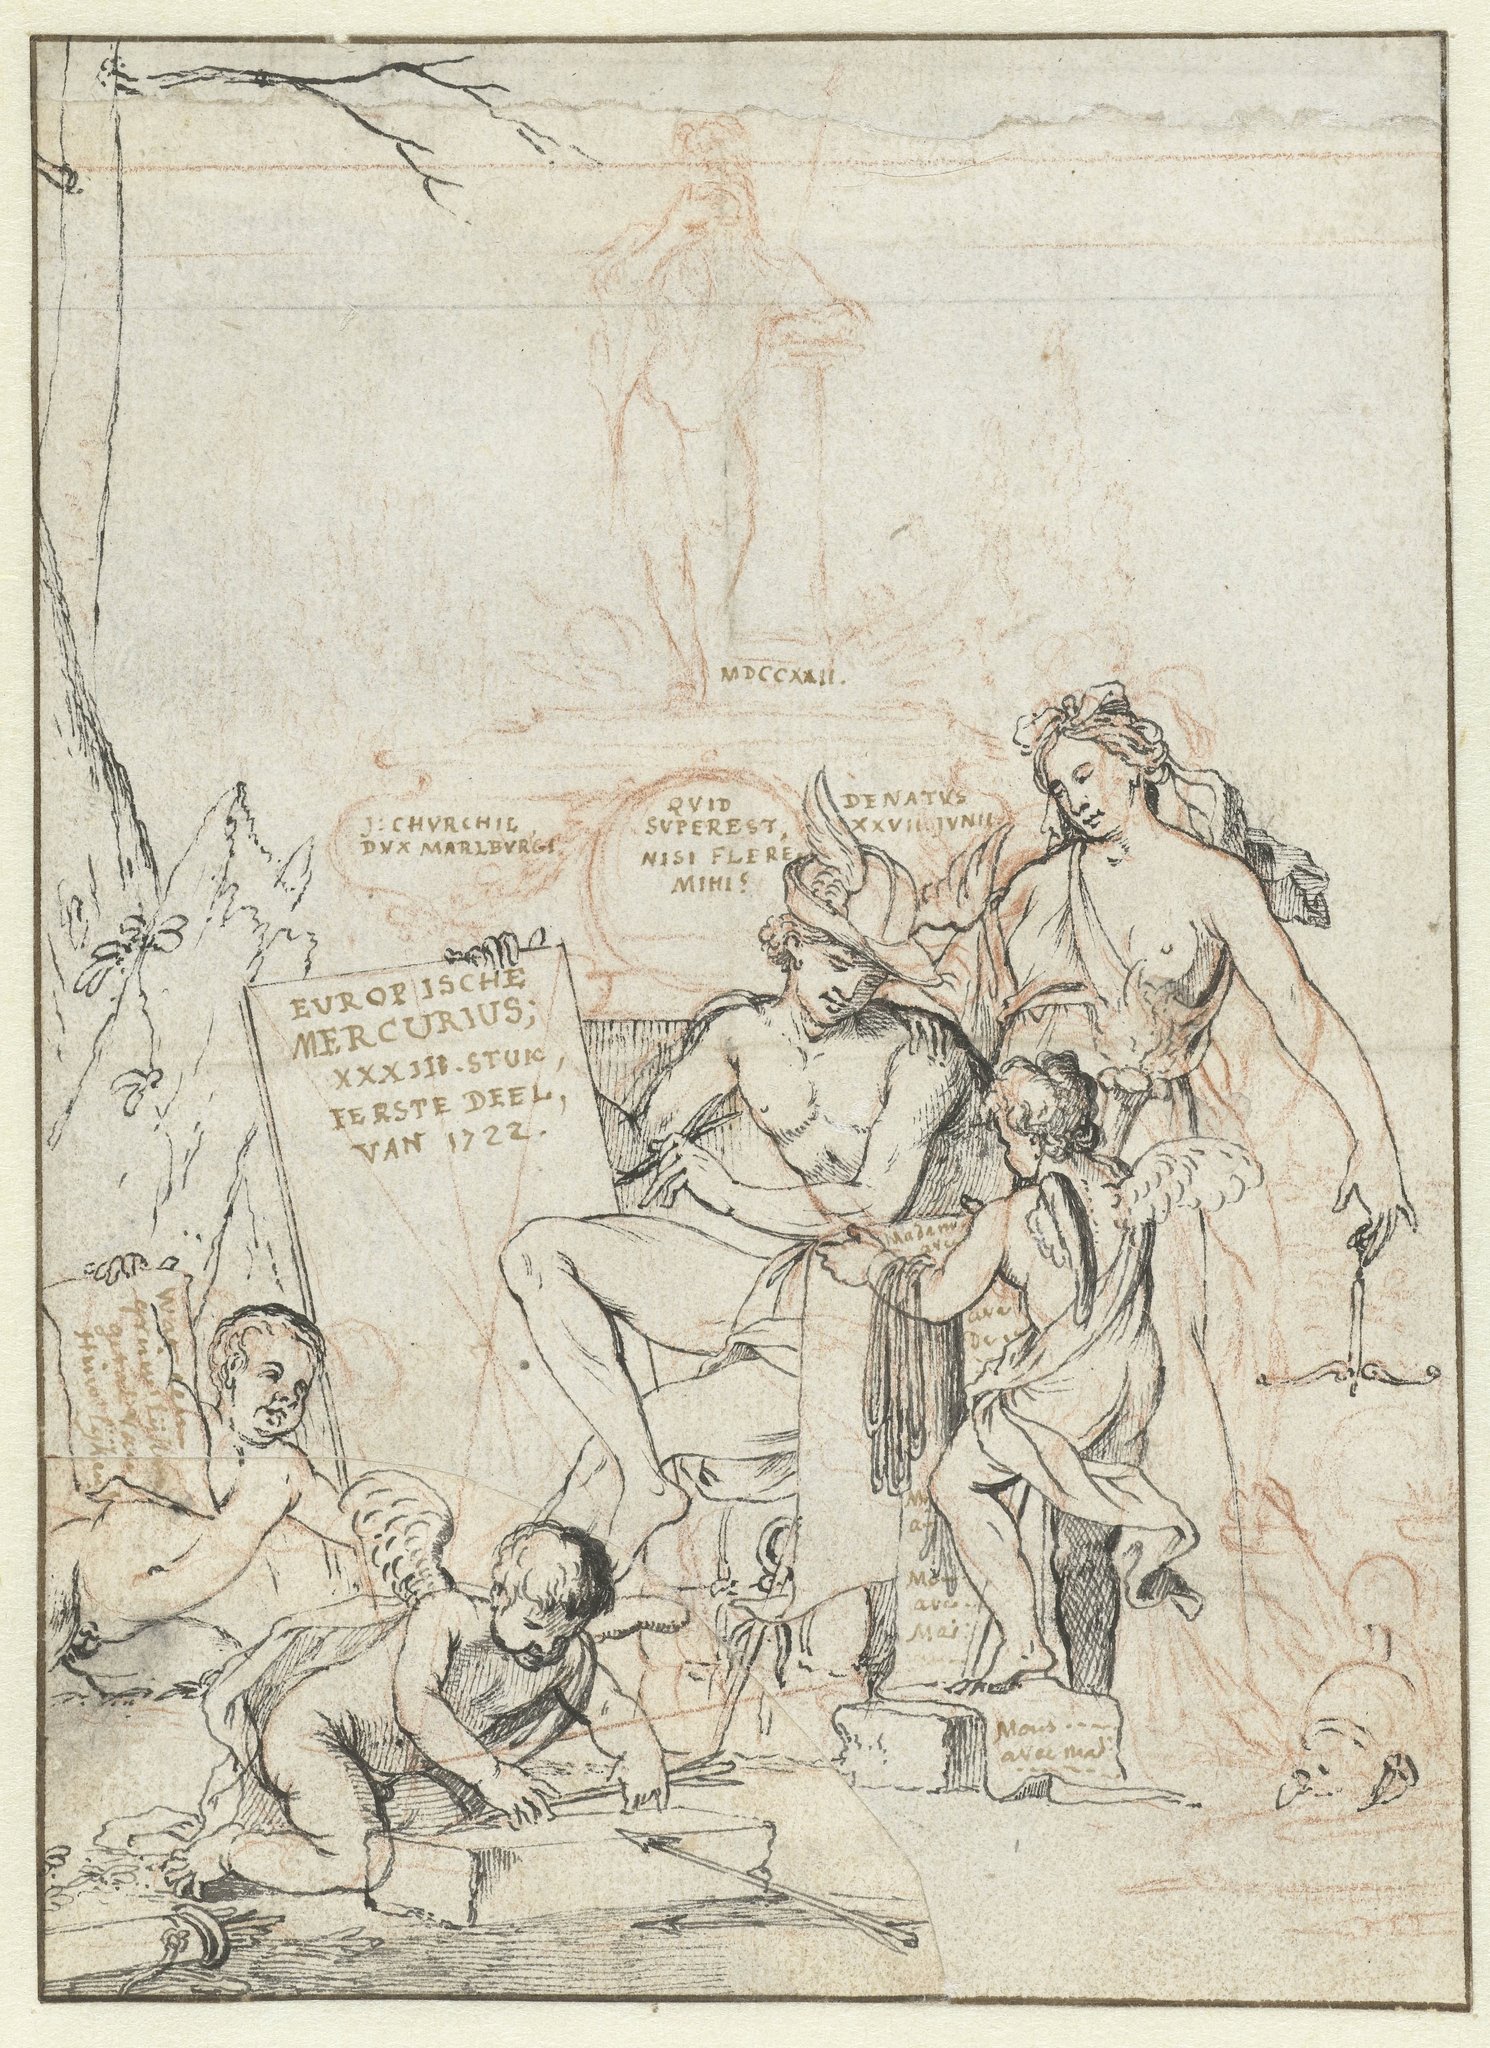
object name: design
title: Ontwerp voor titelblad voor de Europische Mercurius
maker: jan goeree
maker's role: draughtsman, print maker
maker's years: 1670-1731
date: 1722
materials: chalk, ink, paper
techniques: pen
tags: (story of) mercury (hermes)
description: Ontwerp voor een boekillustratie of prent.